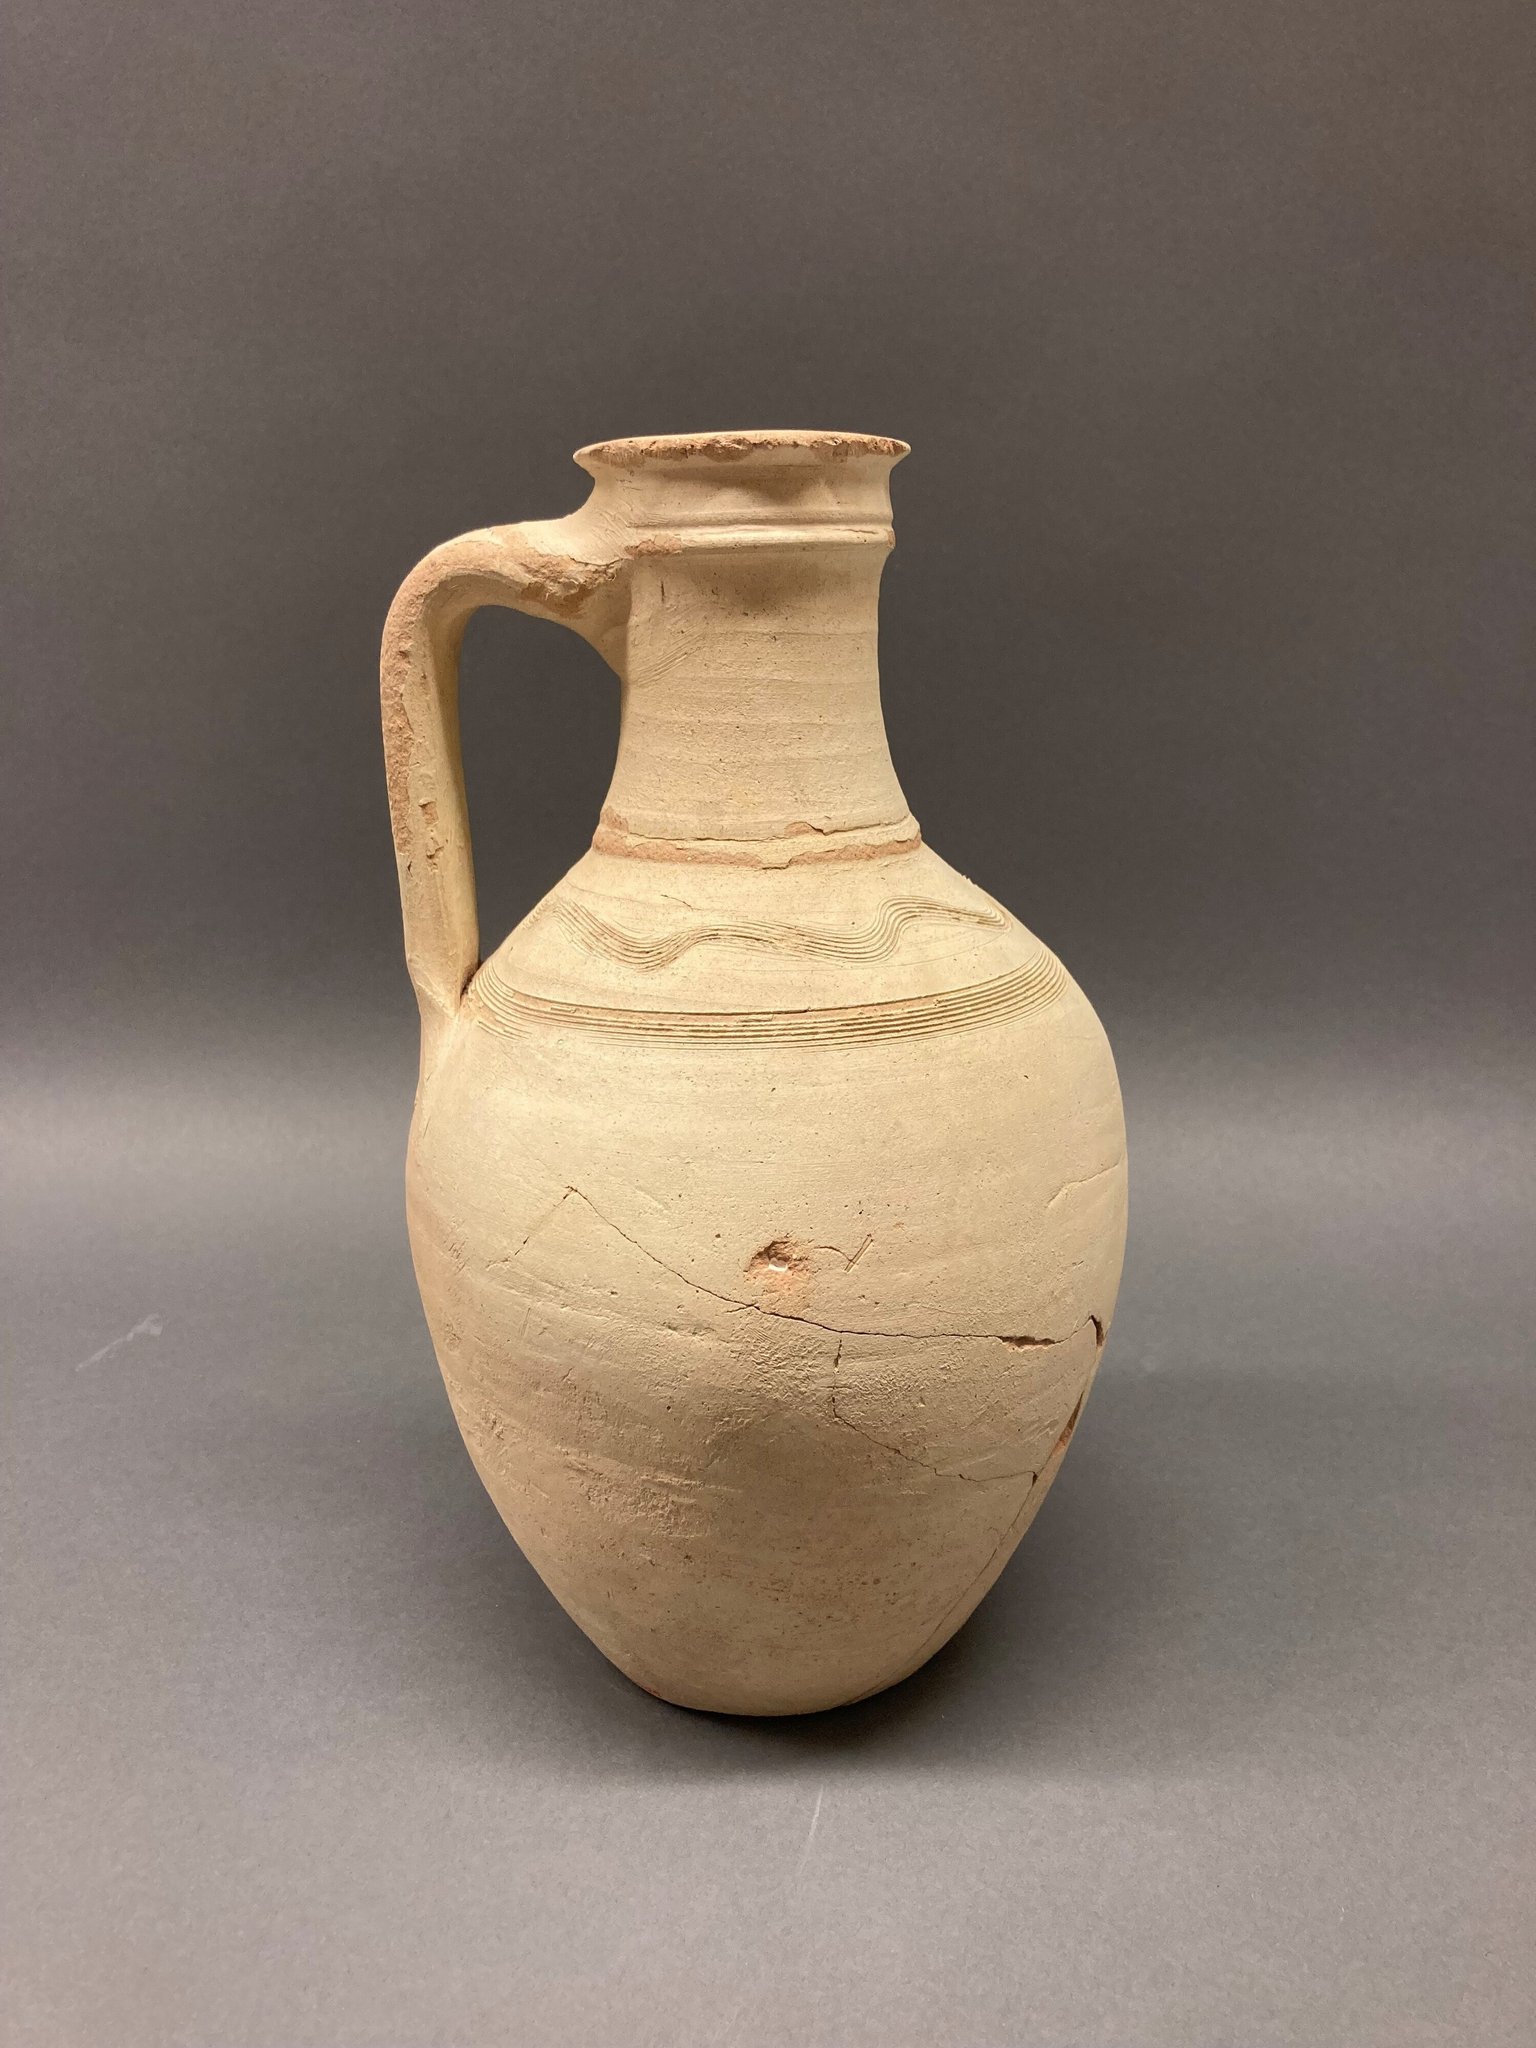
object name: ewer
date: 1001-1200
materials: earthenware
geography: iran